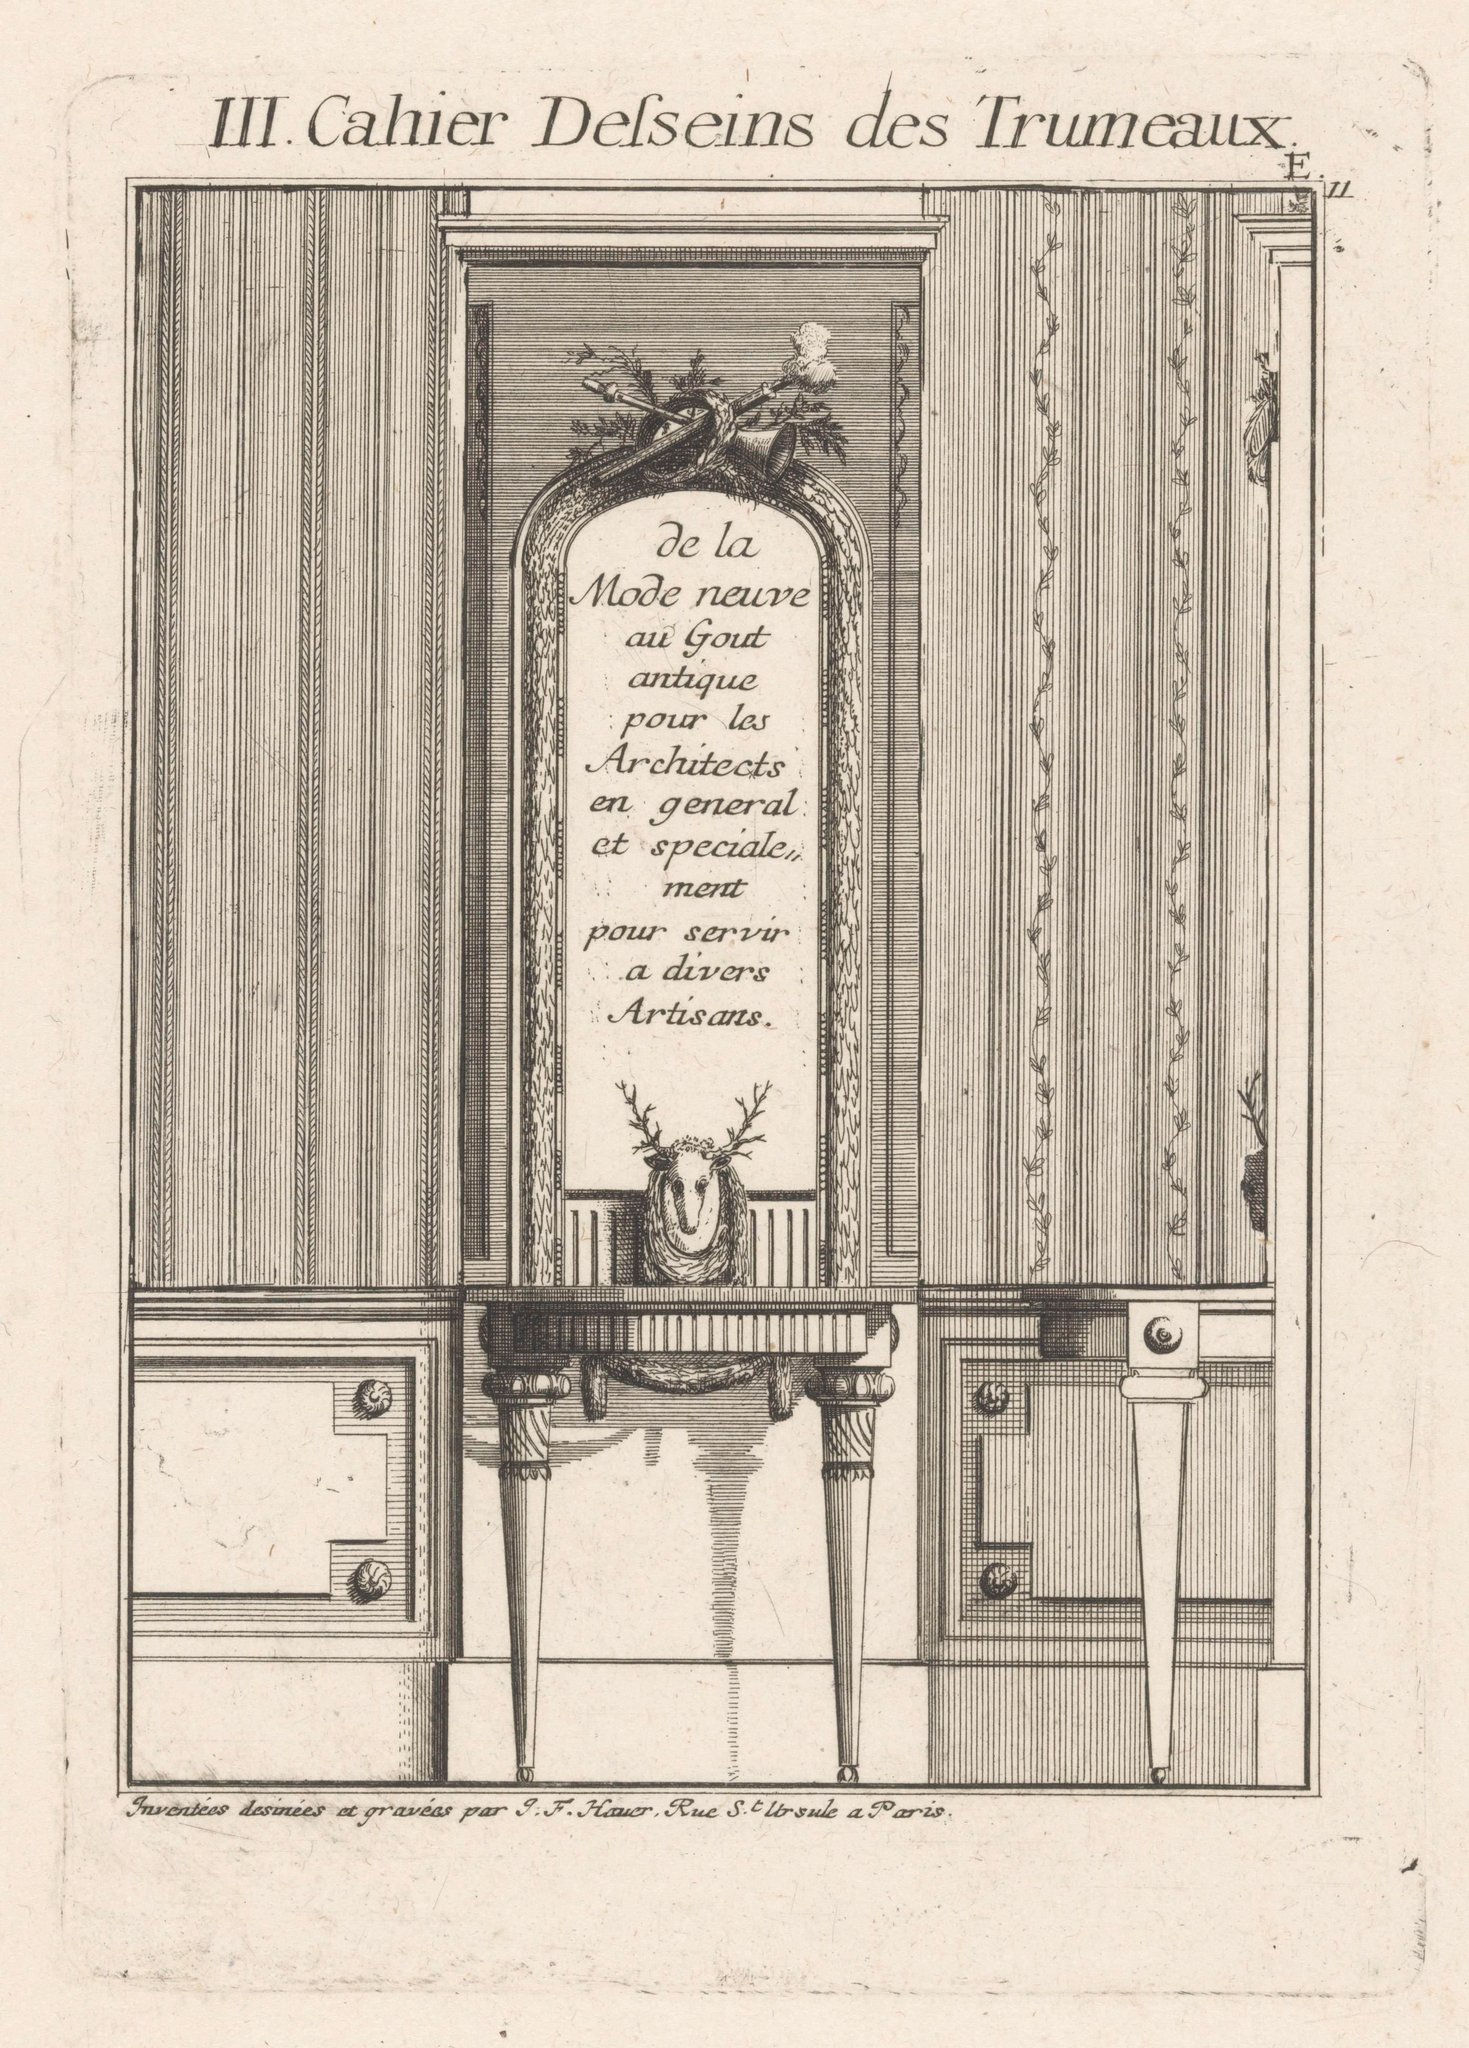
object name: titelprent, frontispice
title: Trumeau met hertenkop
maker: johann thomas hauer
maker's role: print maker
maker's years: 1748-1820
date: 1781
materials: paper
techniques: engraving, etching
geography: paris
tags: half-column, pilaster ~ architecture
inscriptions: collector's mark: Lugt 2228, collector's mark: Lugt 2760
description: Ontwerp voor trumeau met tafel, paneel, hertenkop, guirlandes, lauwerkrans en muziekinstrument.